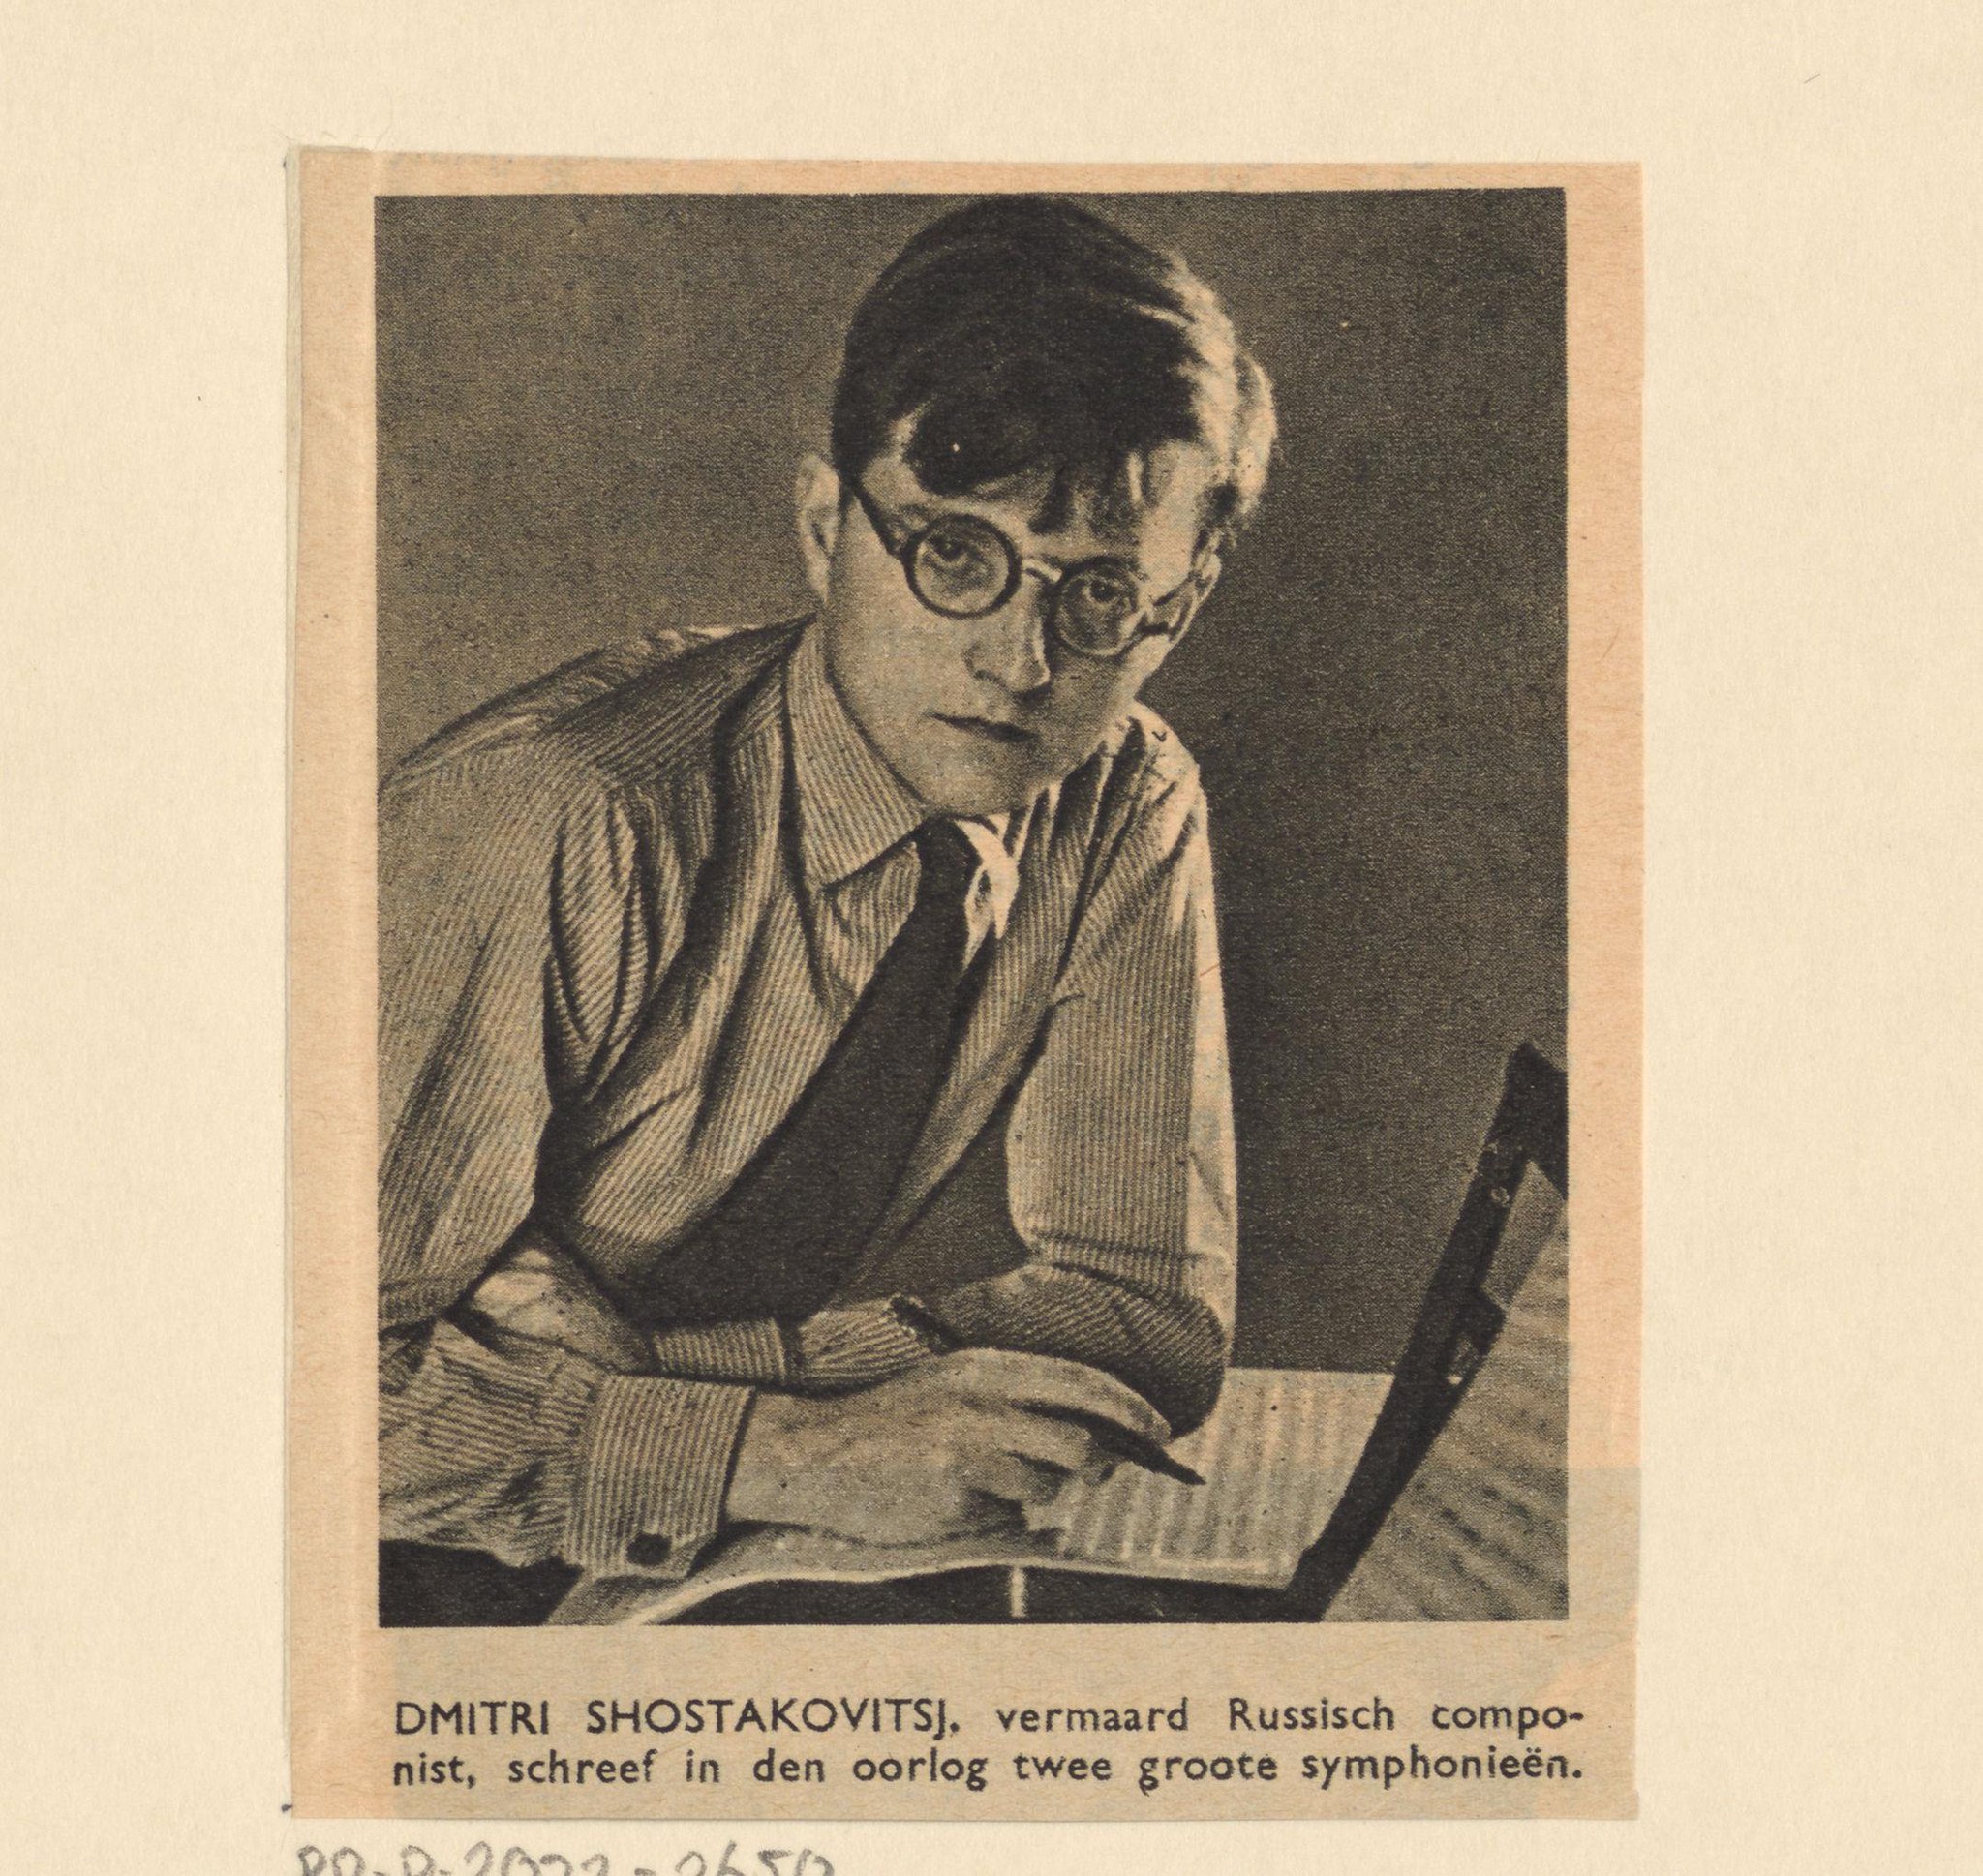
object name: photomechanical print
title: Portret van Dmitri Sjostakovitsj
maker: Anonymous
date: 1875-1930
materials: paper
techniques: photograph, letterpress printing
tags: historical persons, portrait of composer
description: Fotomechanische afdruk uit een onbekende publicatie.